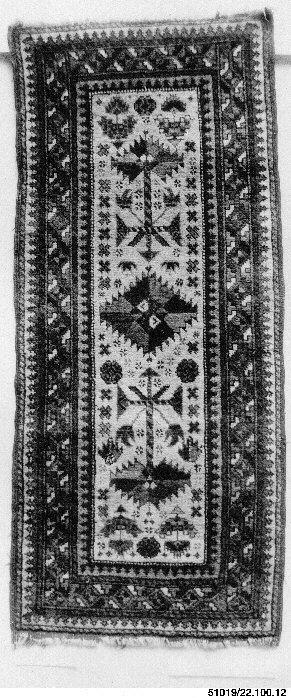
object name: carpet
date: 1801-1900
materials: wool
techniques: asymmetrically knotted pile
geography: central asia